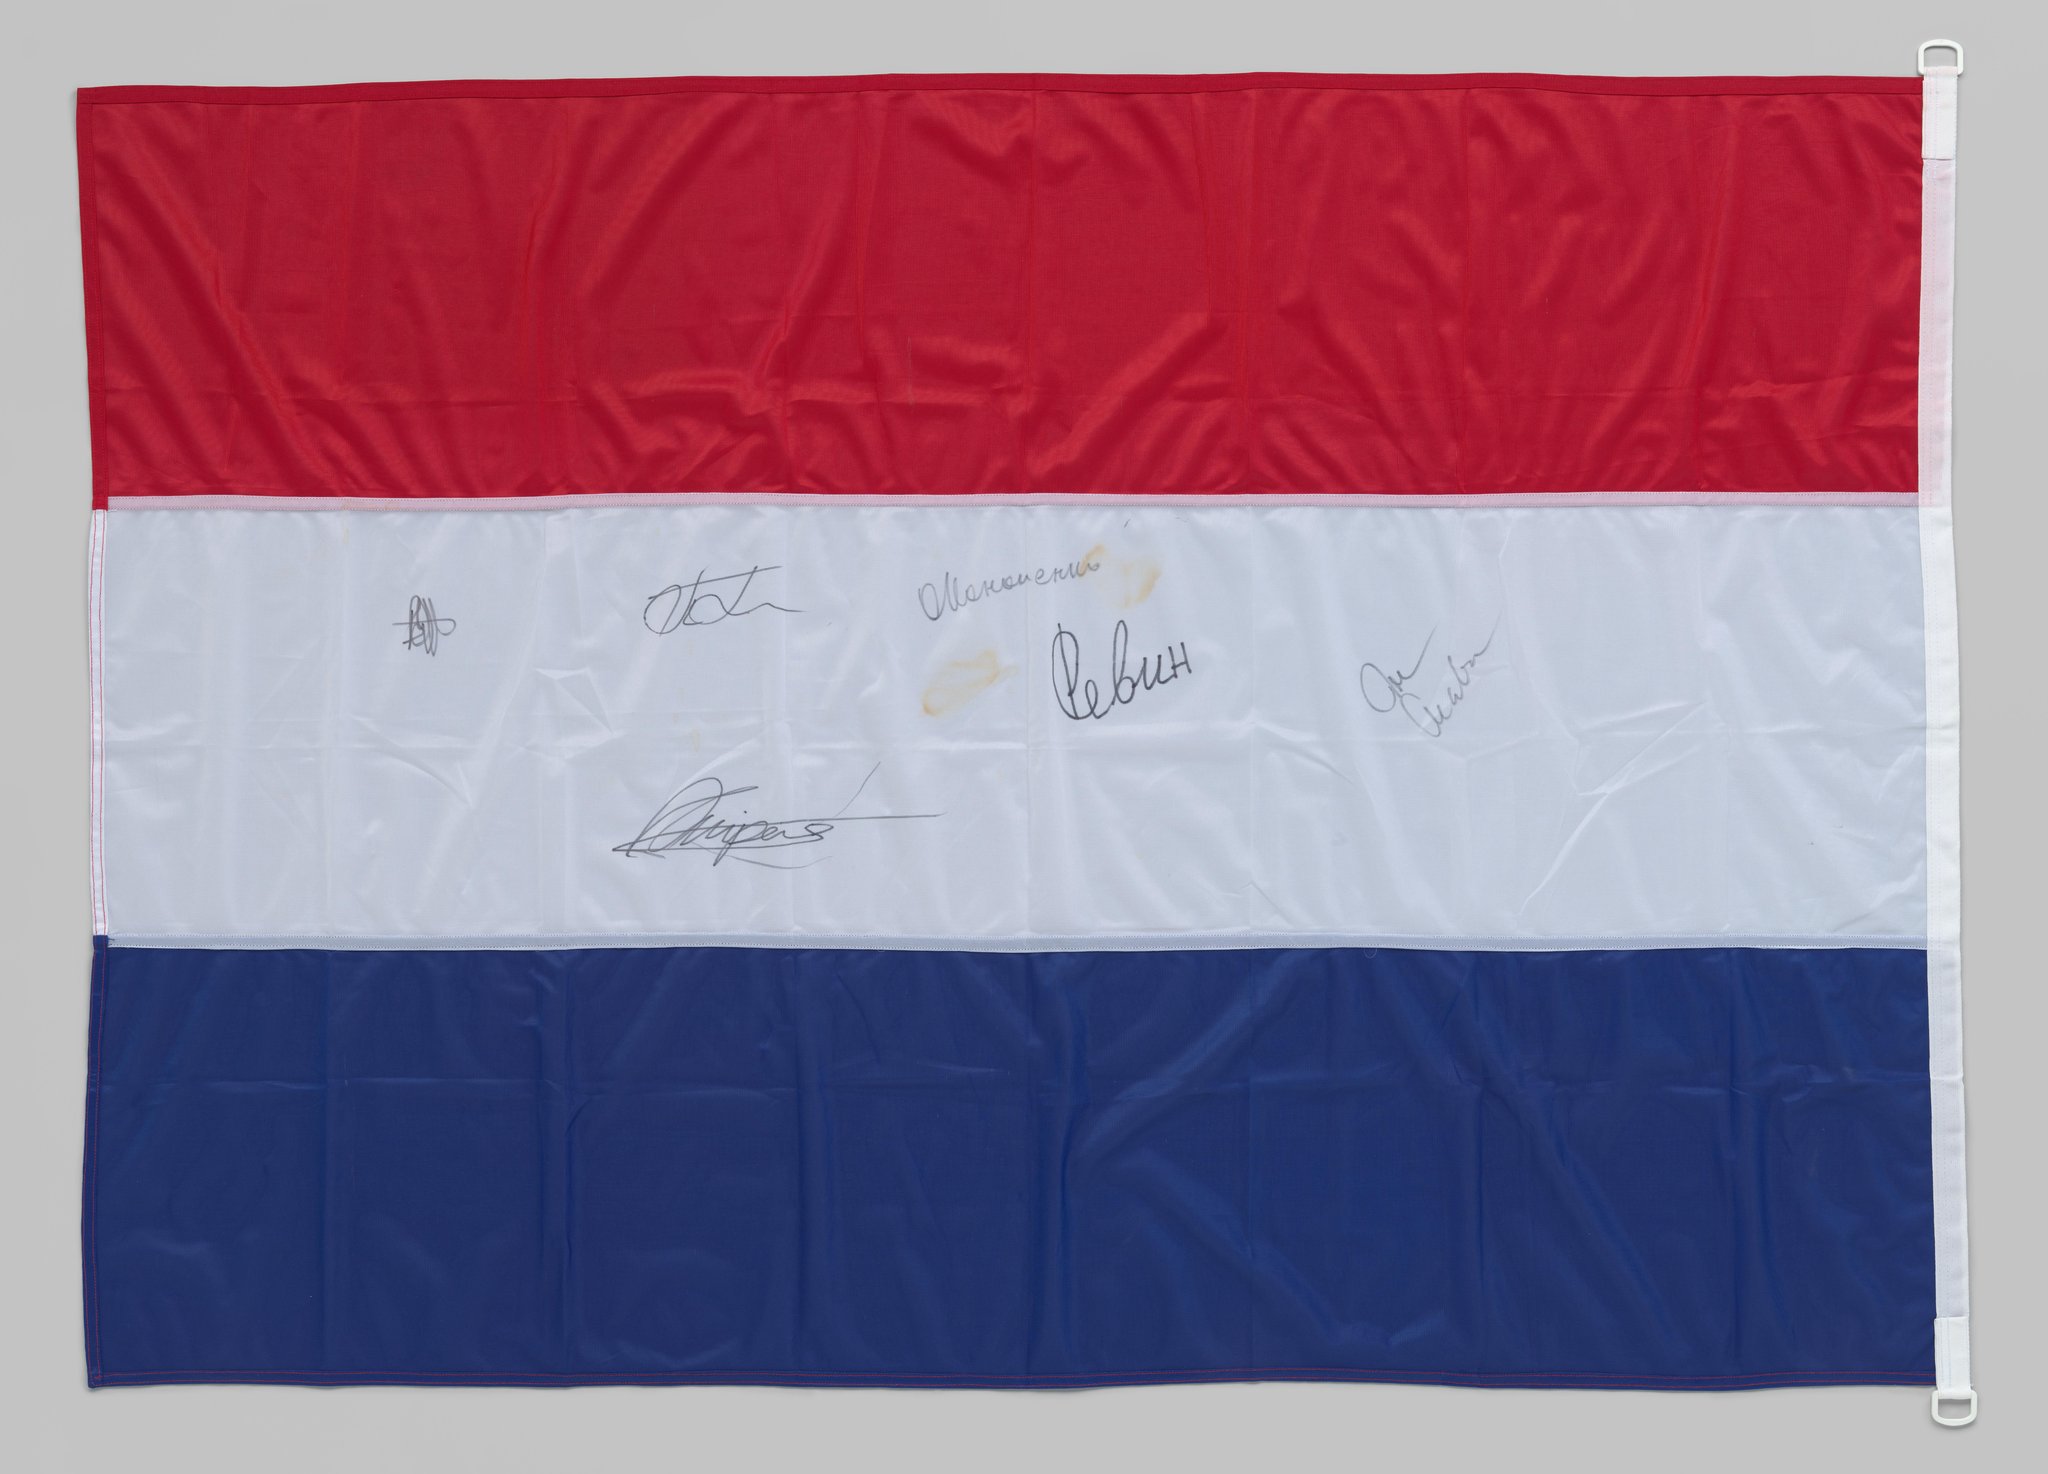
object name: flag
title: Dutch Flag International Space Station ISS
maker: Anonymous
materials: textile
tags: netherlands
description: Dutch astronaut André Kuipers took this flag with him to the International Space Station ISS in 2011. Thus, during his media appearances in space, the Dutch tricolour was in the background and visible to the entire world. It returned to Earth in 2012 as padding for the cargo in the Dragon spacecraft, which was temporarily docked at the ISS. Kuipers and his fellow astronauts put their names on the flag.